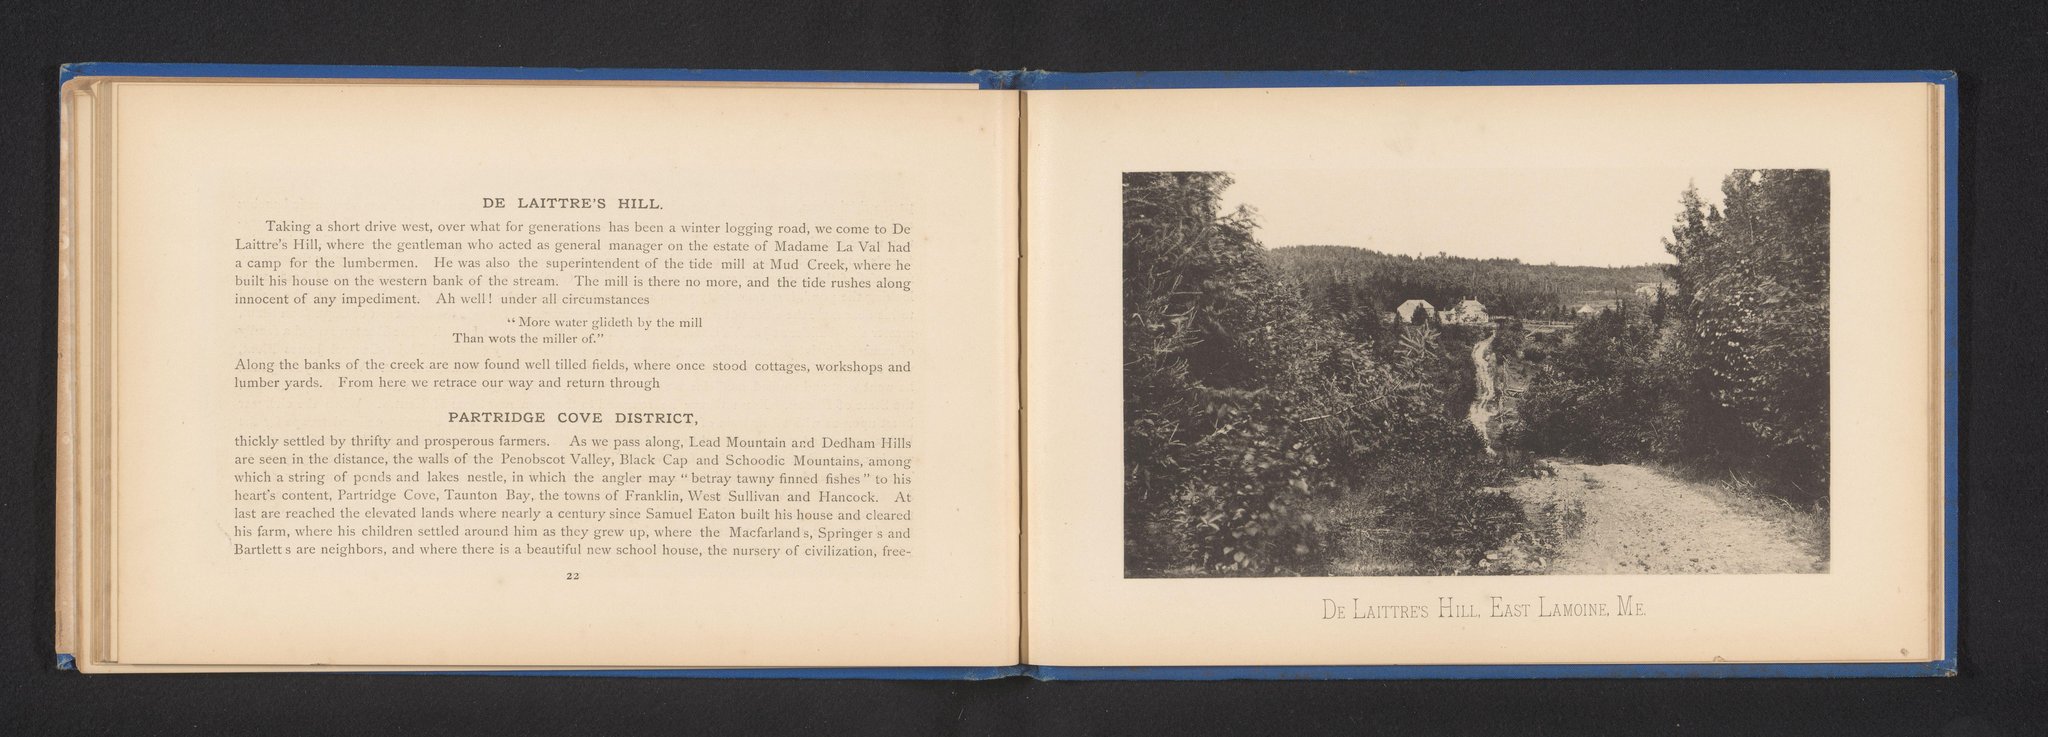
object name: photomechanical print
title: De Laittre's Hill, East Lamoine, Me.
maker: Anonymous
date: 1882-1887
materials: paper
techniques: photograph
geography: east lamoine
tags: low hill country, landscapes, façade (of house or building)